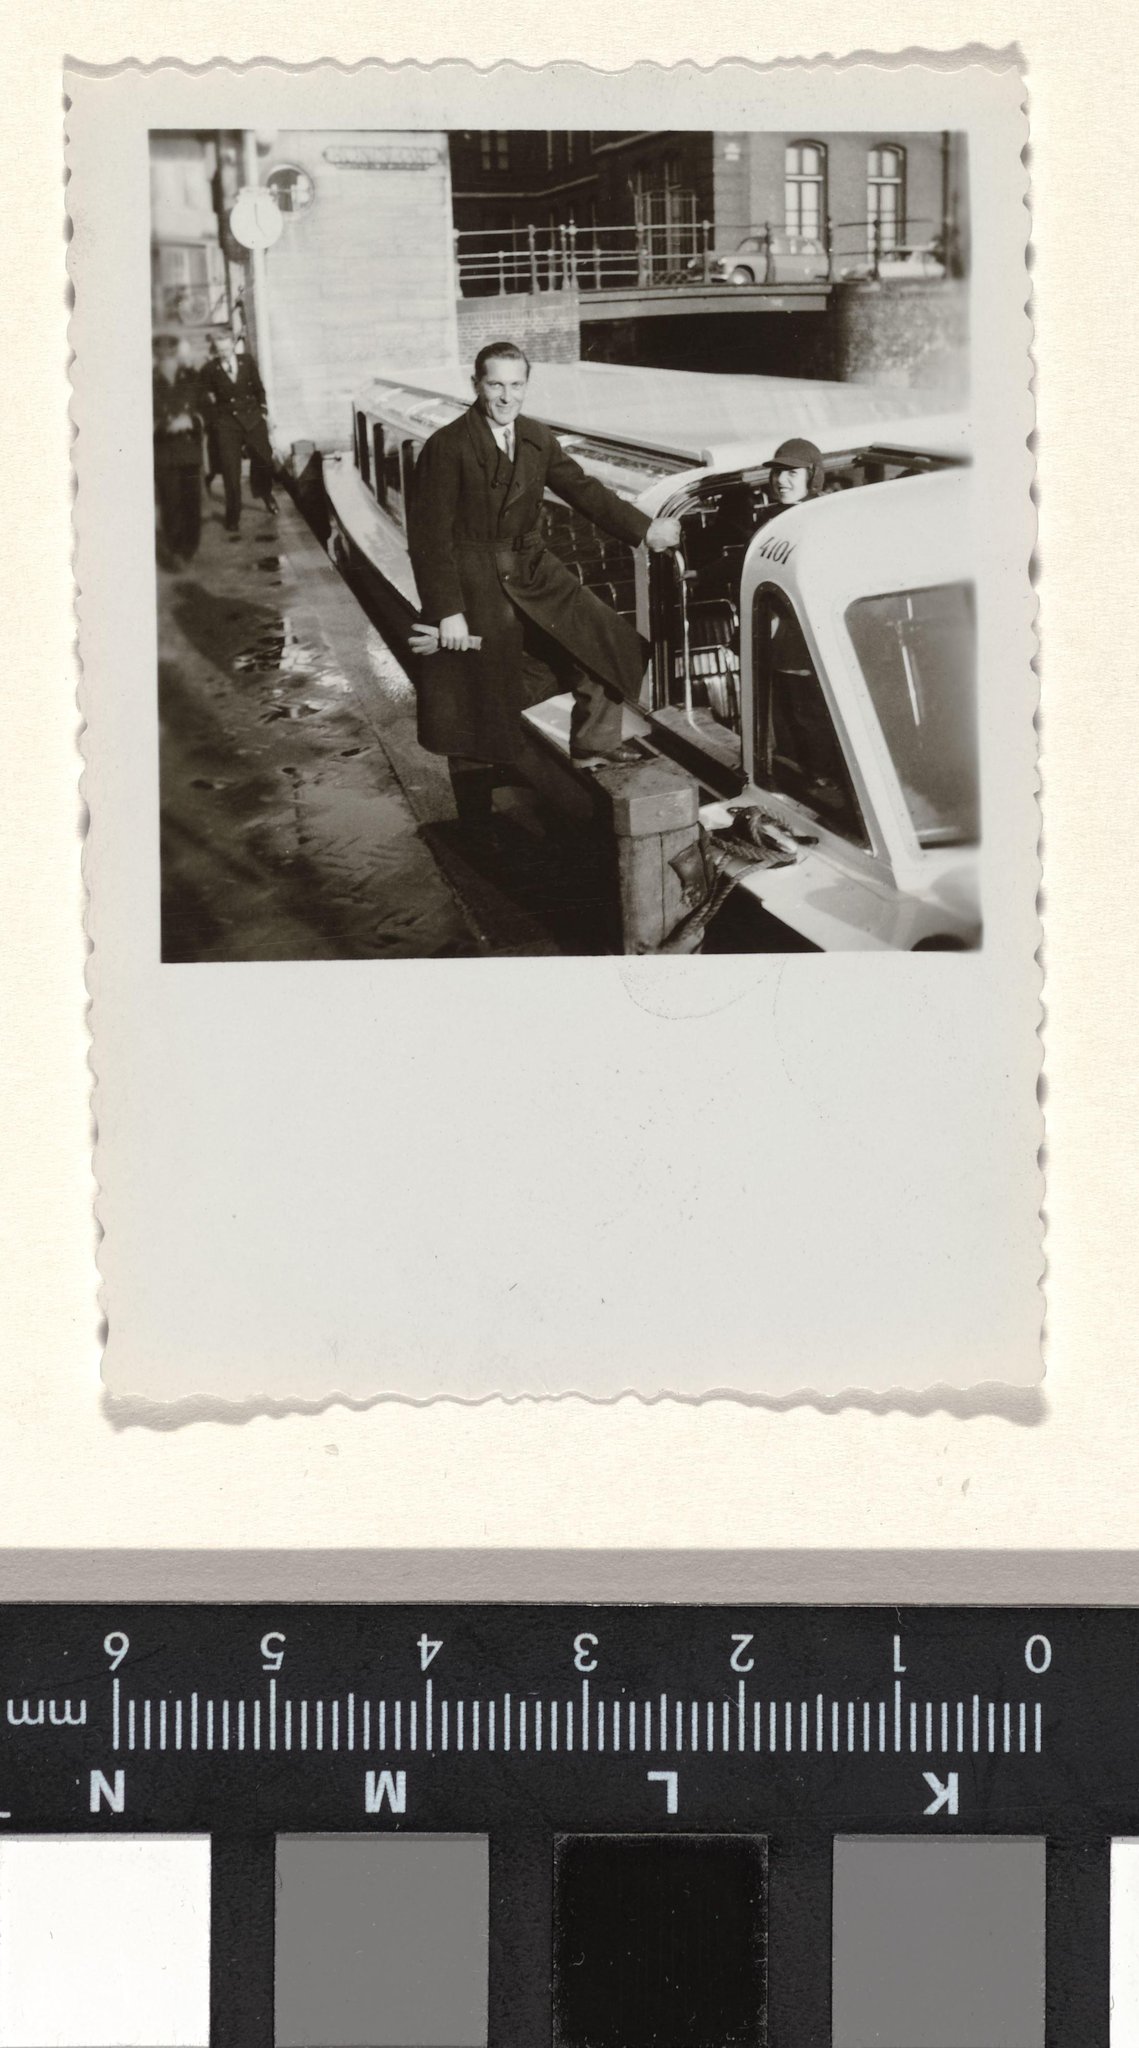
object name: photograph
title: Gideon Elon, de derde echtgenoot van Isabel Wachenheimer, bij een rondvaartboot, met zijn linkervoet op de reling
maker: Anonymous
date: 1956-1970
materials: photographic support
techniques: gelatin silver print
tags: gideon elon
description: Gideon Elon, de derde echtgenoot van Isabel Wachenheimer, bij een rondvaartboot, met zijn linkervoet op de reling